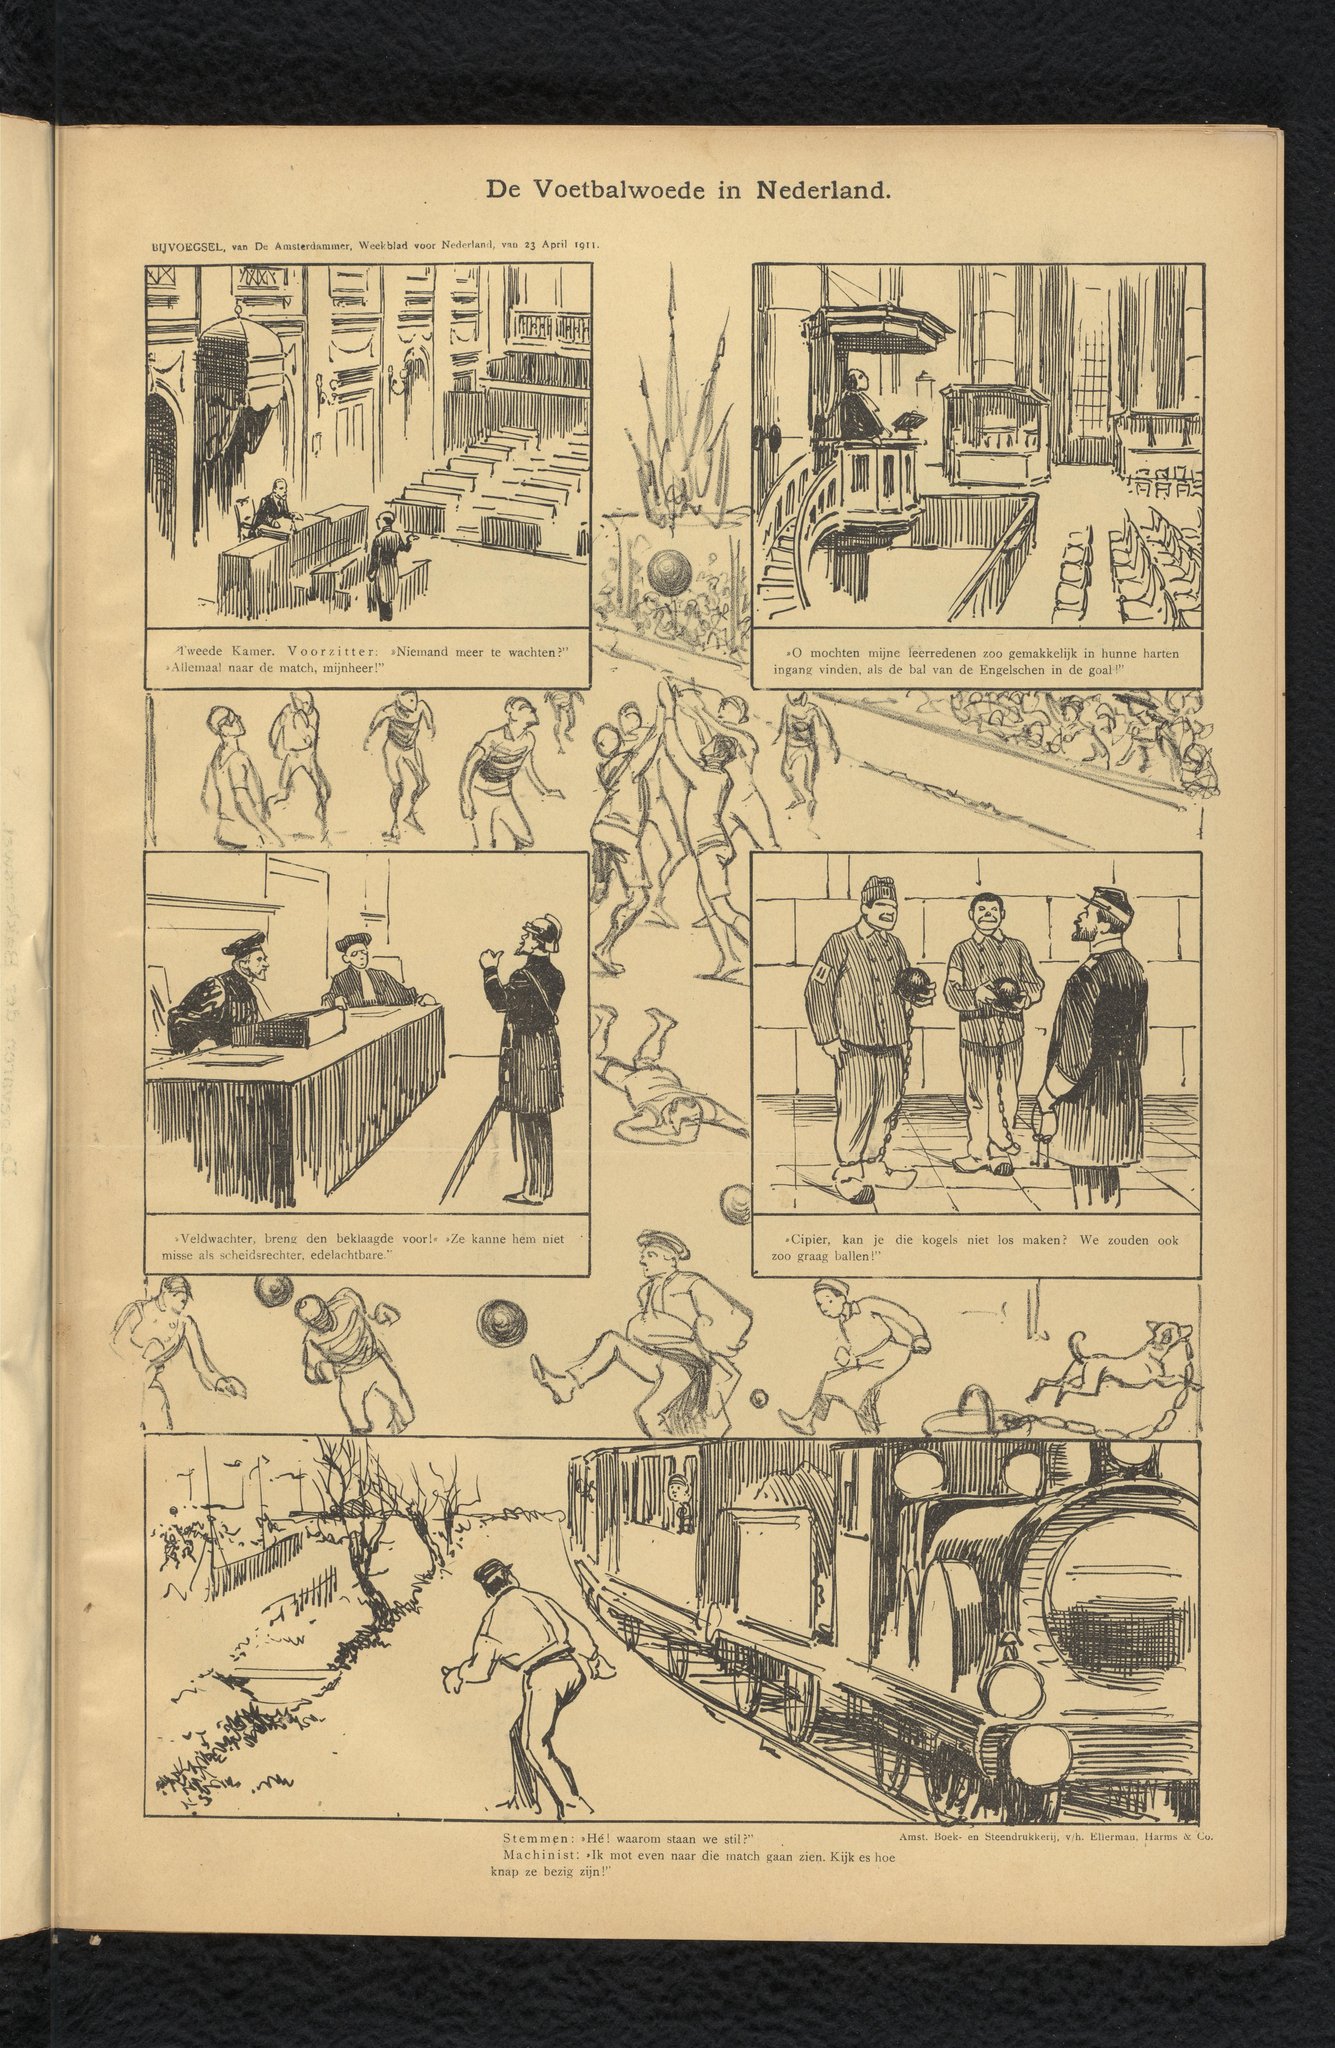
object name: cartoon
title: De Voetbalwoede in Nederland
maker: johan braakensiek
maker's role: draughtsman, print maker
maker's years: 1858-1940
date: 1911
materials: paper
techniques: lithograph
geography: netherlands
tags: soccer, football (early names: soule, choule, cholle), political caricatures and satires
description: In meerdere kleine voorstellingen blijkt hoe iedereen in het hele land in de ban is van het voetballen, naar aanleiding van de interland tussen Nederland en Engeland, gespeeld op 17 april (uitslag: 0-1).